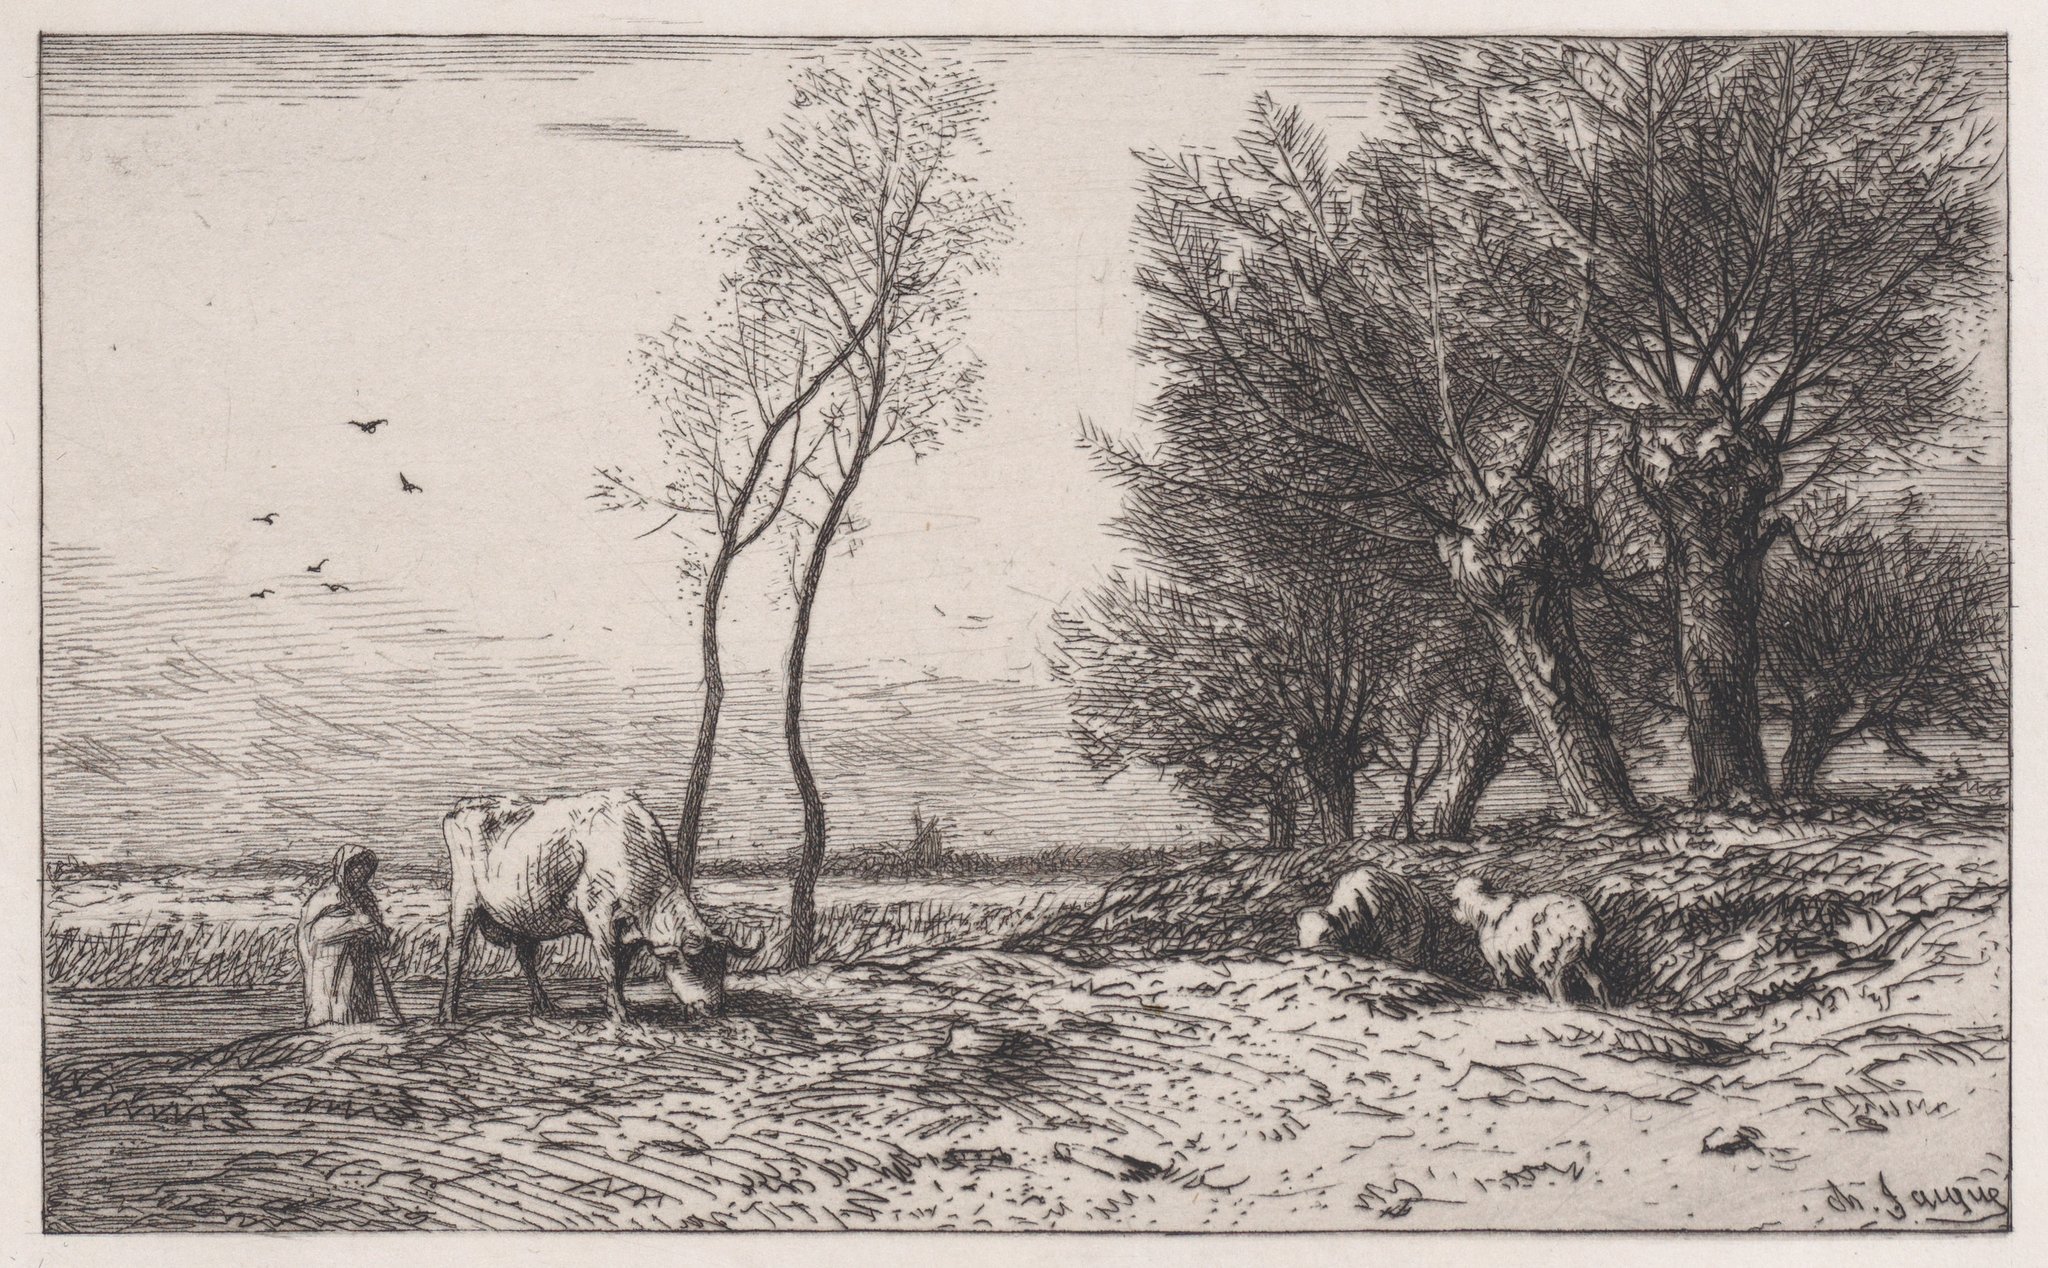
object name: print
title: L'Hiver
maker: charles émile jacque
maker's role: artist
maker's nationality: french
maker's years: 1813-1894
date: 1867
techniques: drypoint, etching